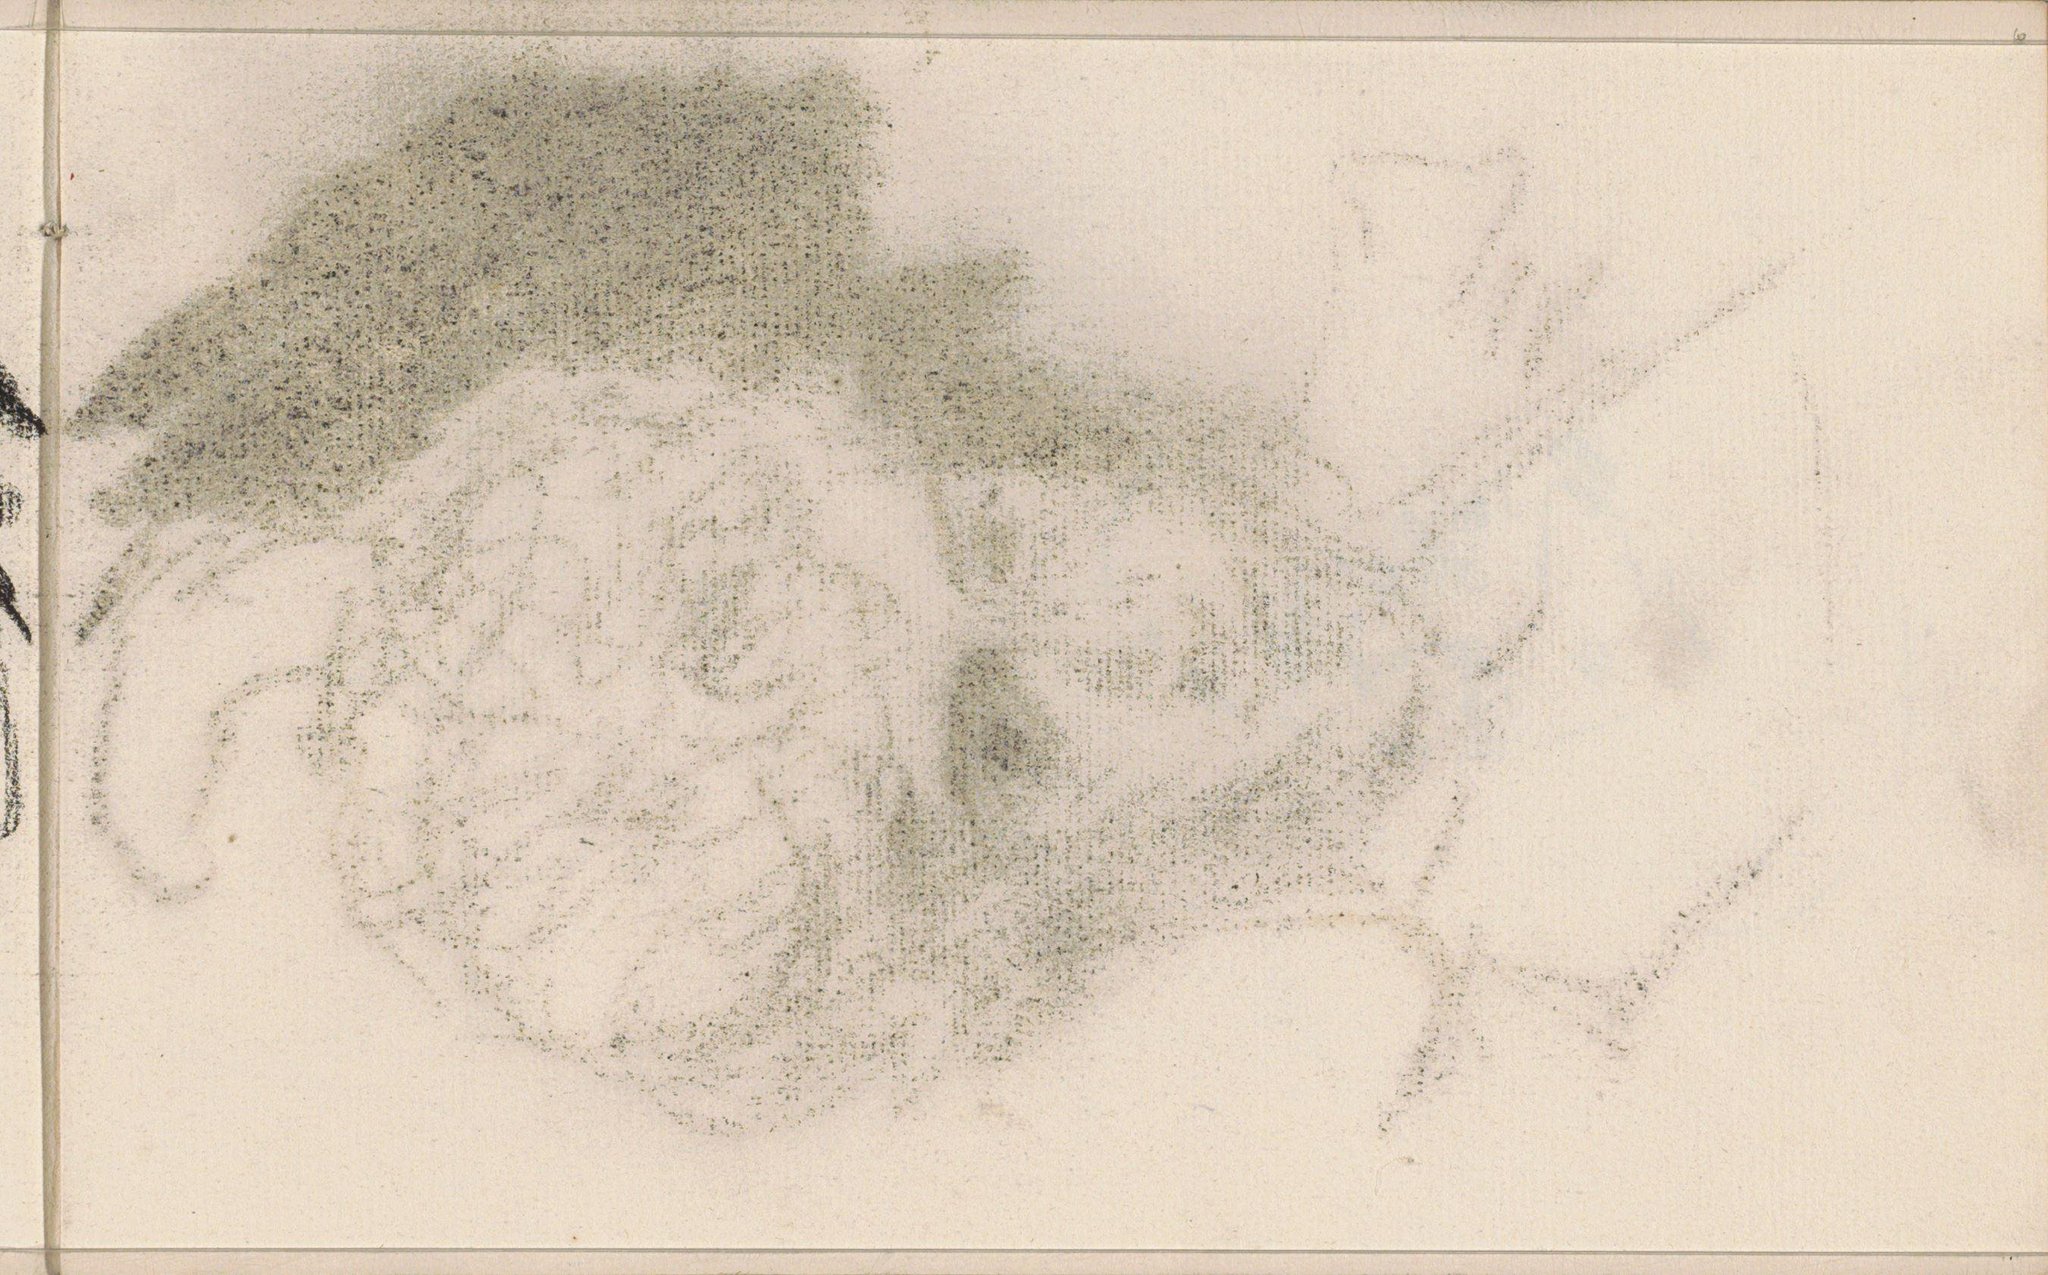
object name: sketchbook leaf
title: Abklatsch van de krijttekening op pagina 9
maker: isaac israels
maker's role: draughtsman, painter, print maker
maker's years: 1865-1934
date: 1886-1903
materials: paper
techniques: printmaking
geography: amsterdam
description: Pagina 10 uit schetsboek XXXIII met 47 pagina's.